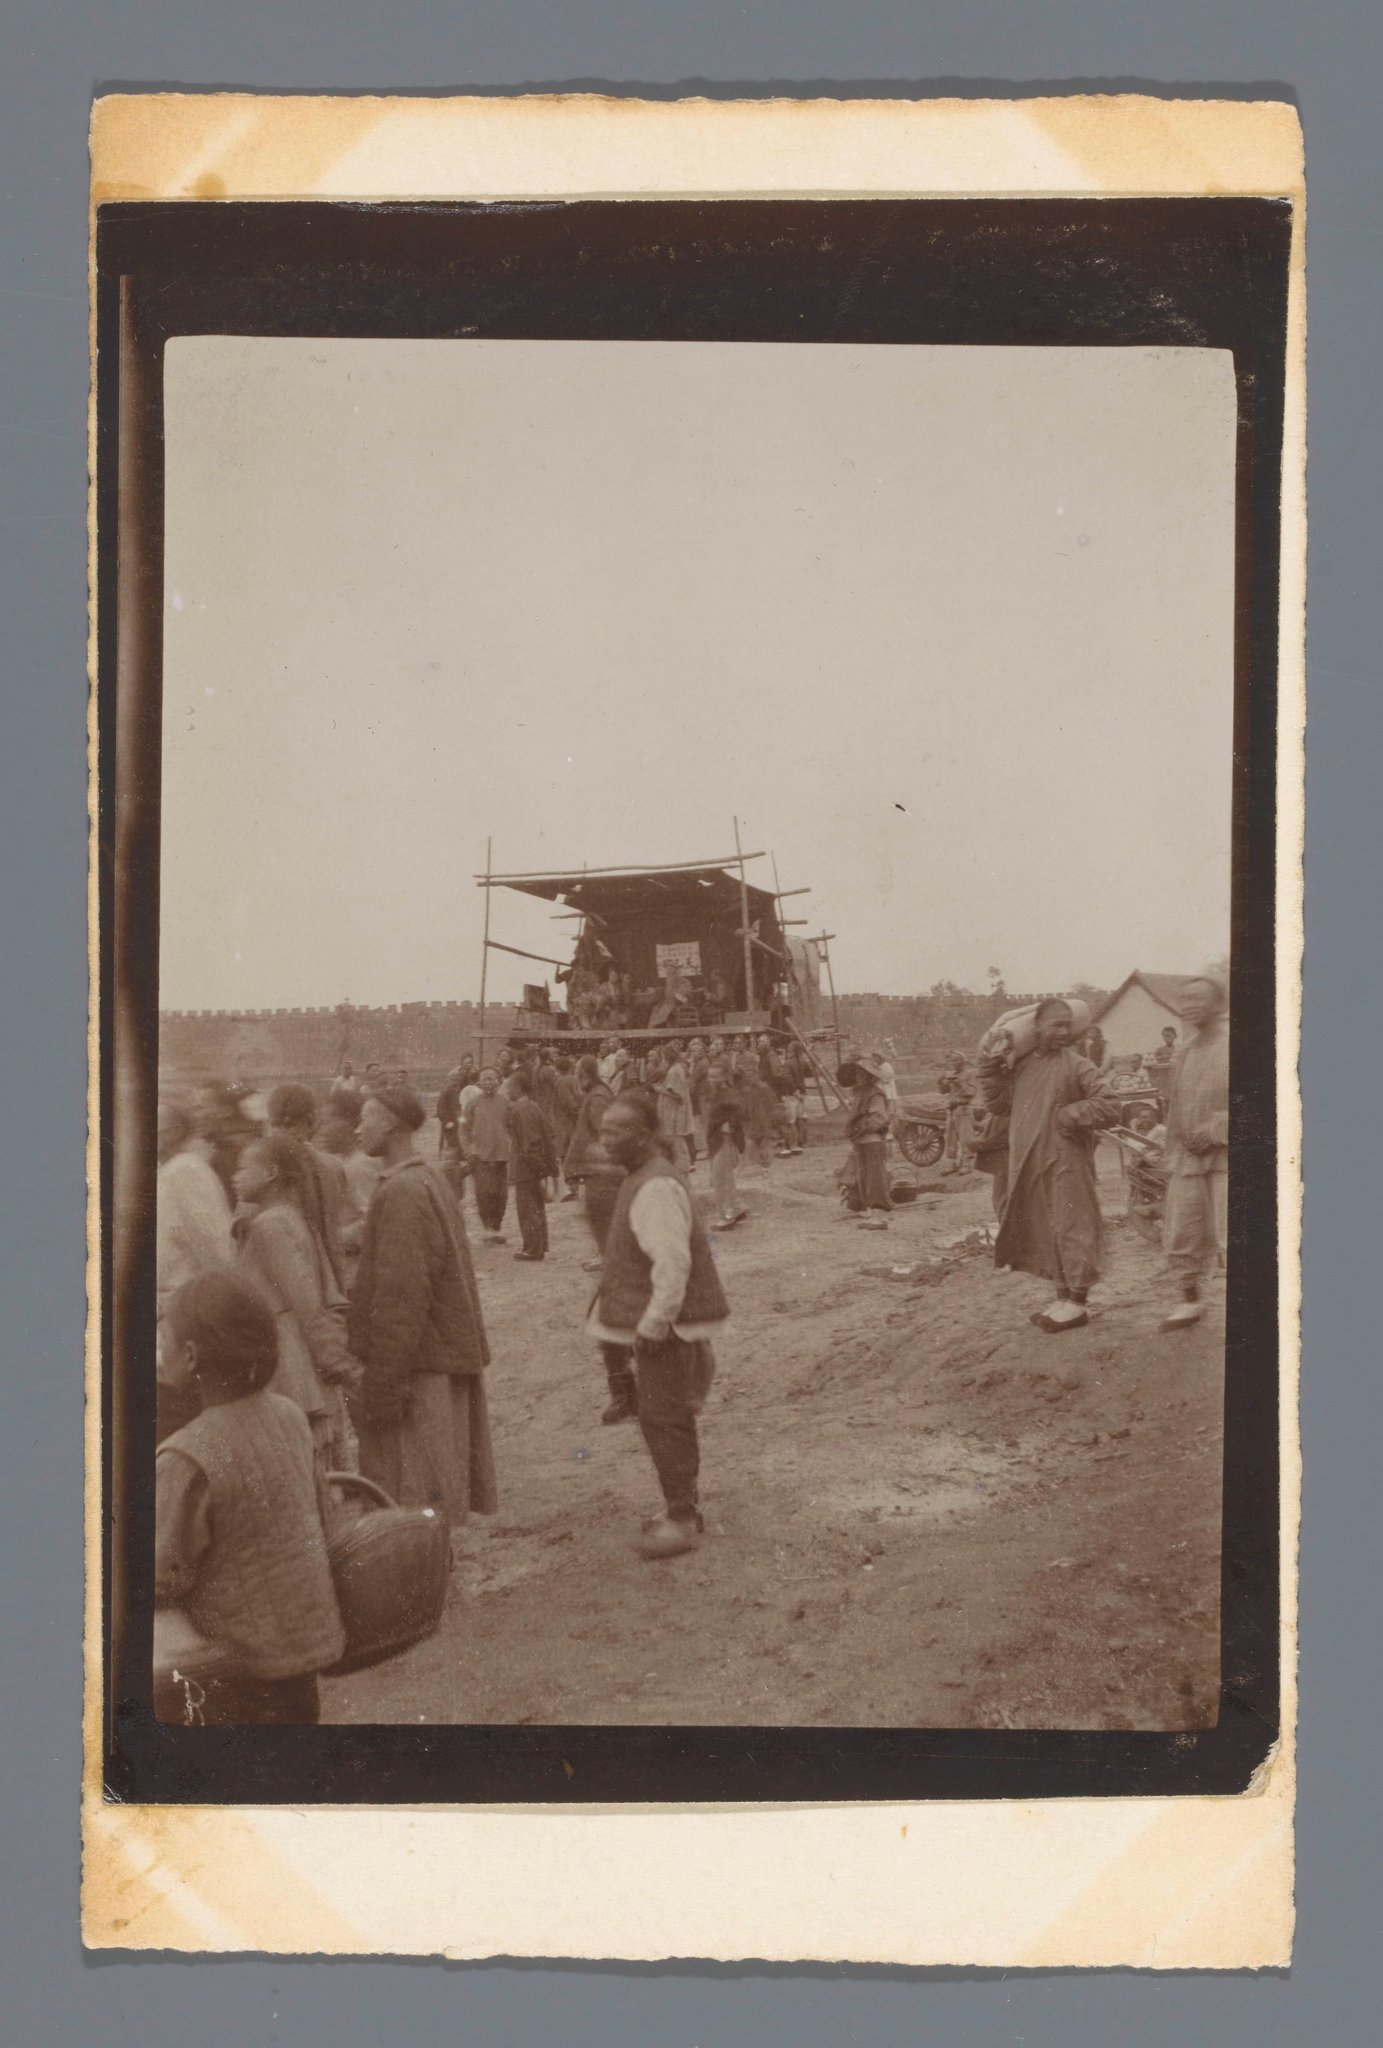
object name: photograph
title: Toeschouwers bij een optreden op een podium bij een muur (de Chinese muur?), China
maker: jan adriani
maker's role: fotograaf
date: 1907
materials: cardboard, photographic support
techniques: collodion silver print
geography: china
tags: the audience ~ art performance, china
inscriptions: inscription: ‘Maatschappij "Arti et Amicitiae" (...) Hiermede noodigen wij U met Uwe Dames uit tot bijwoning der / Kunstbeschouwing (...) / op Vrijdag 30 Maart 1906 (...)’